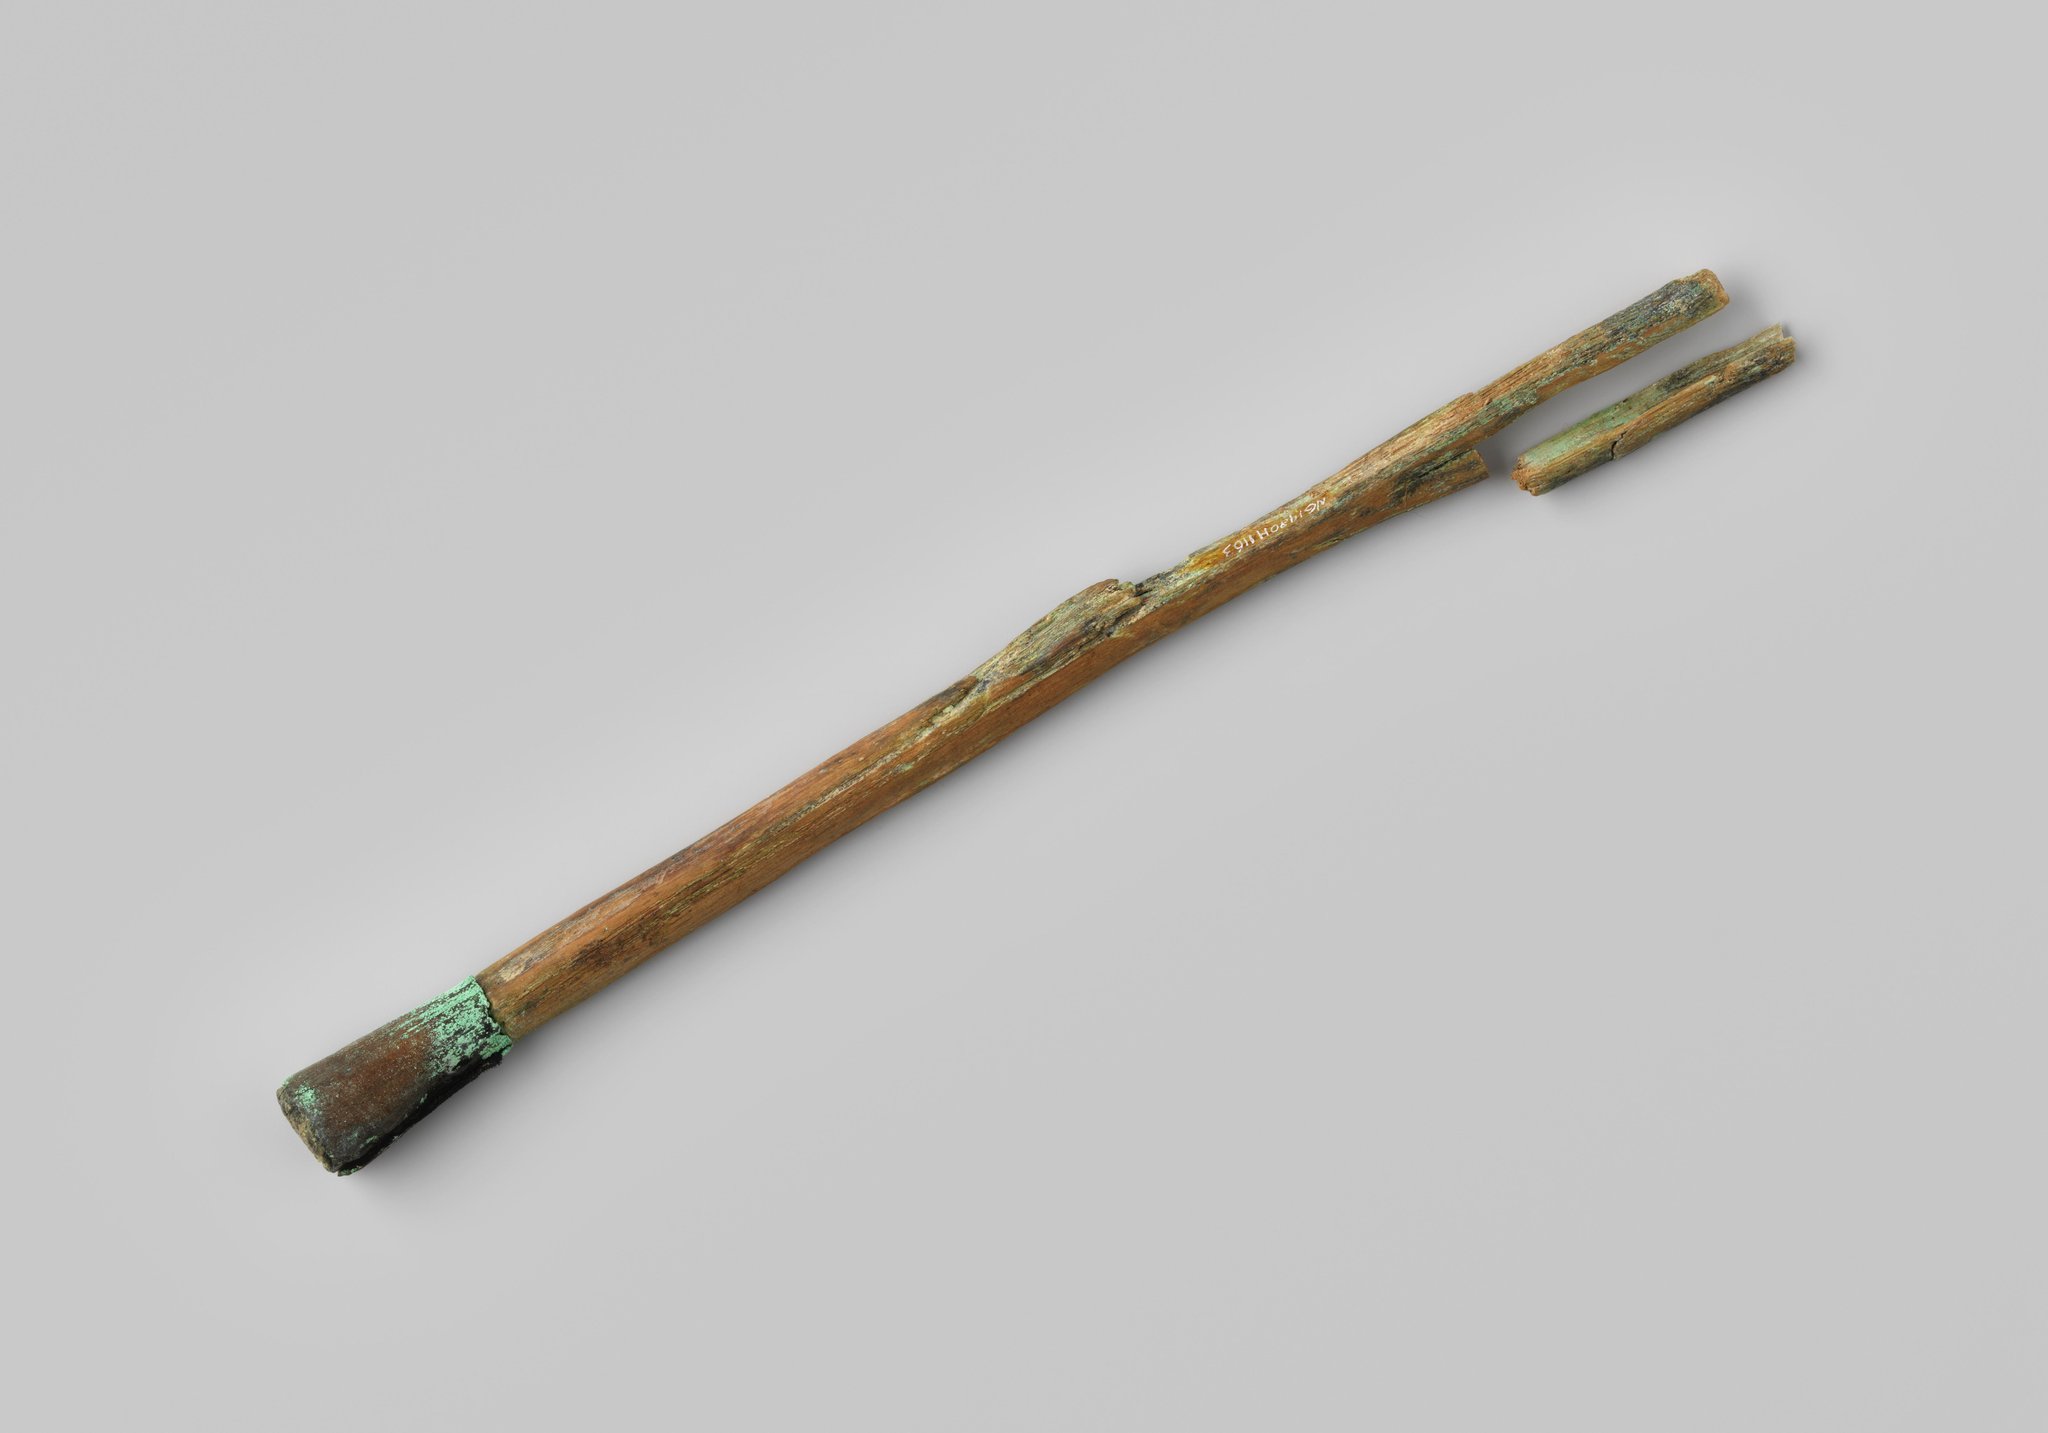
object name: rammer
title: Laadstok van een handwapen uit het wrak van de Oost-Indiëvaarder Hollandia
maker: Anonymous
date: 1700-1743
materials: copper, wood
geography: netherlands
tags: verenigde oostindische compagnie, hollandia (schip), annet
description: Hand weapon, ramrod; fragm of wood shaft, everted conical end fitted with copper band.